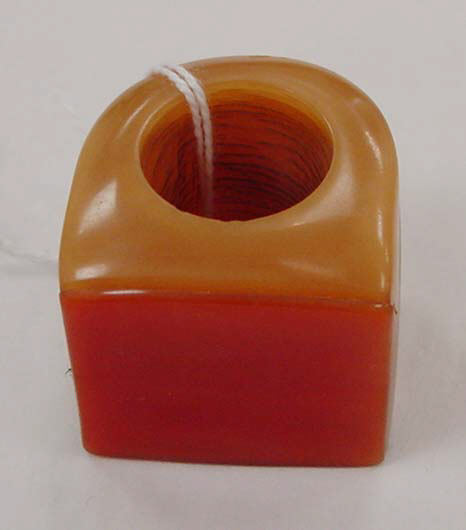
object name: ring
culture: chinese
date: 1801-1900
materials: jade